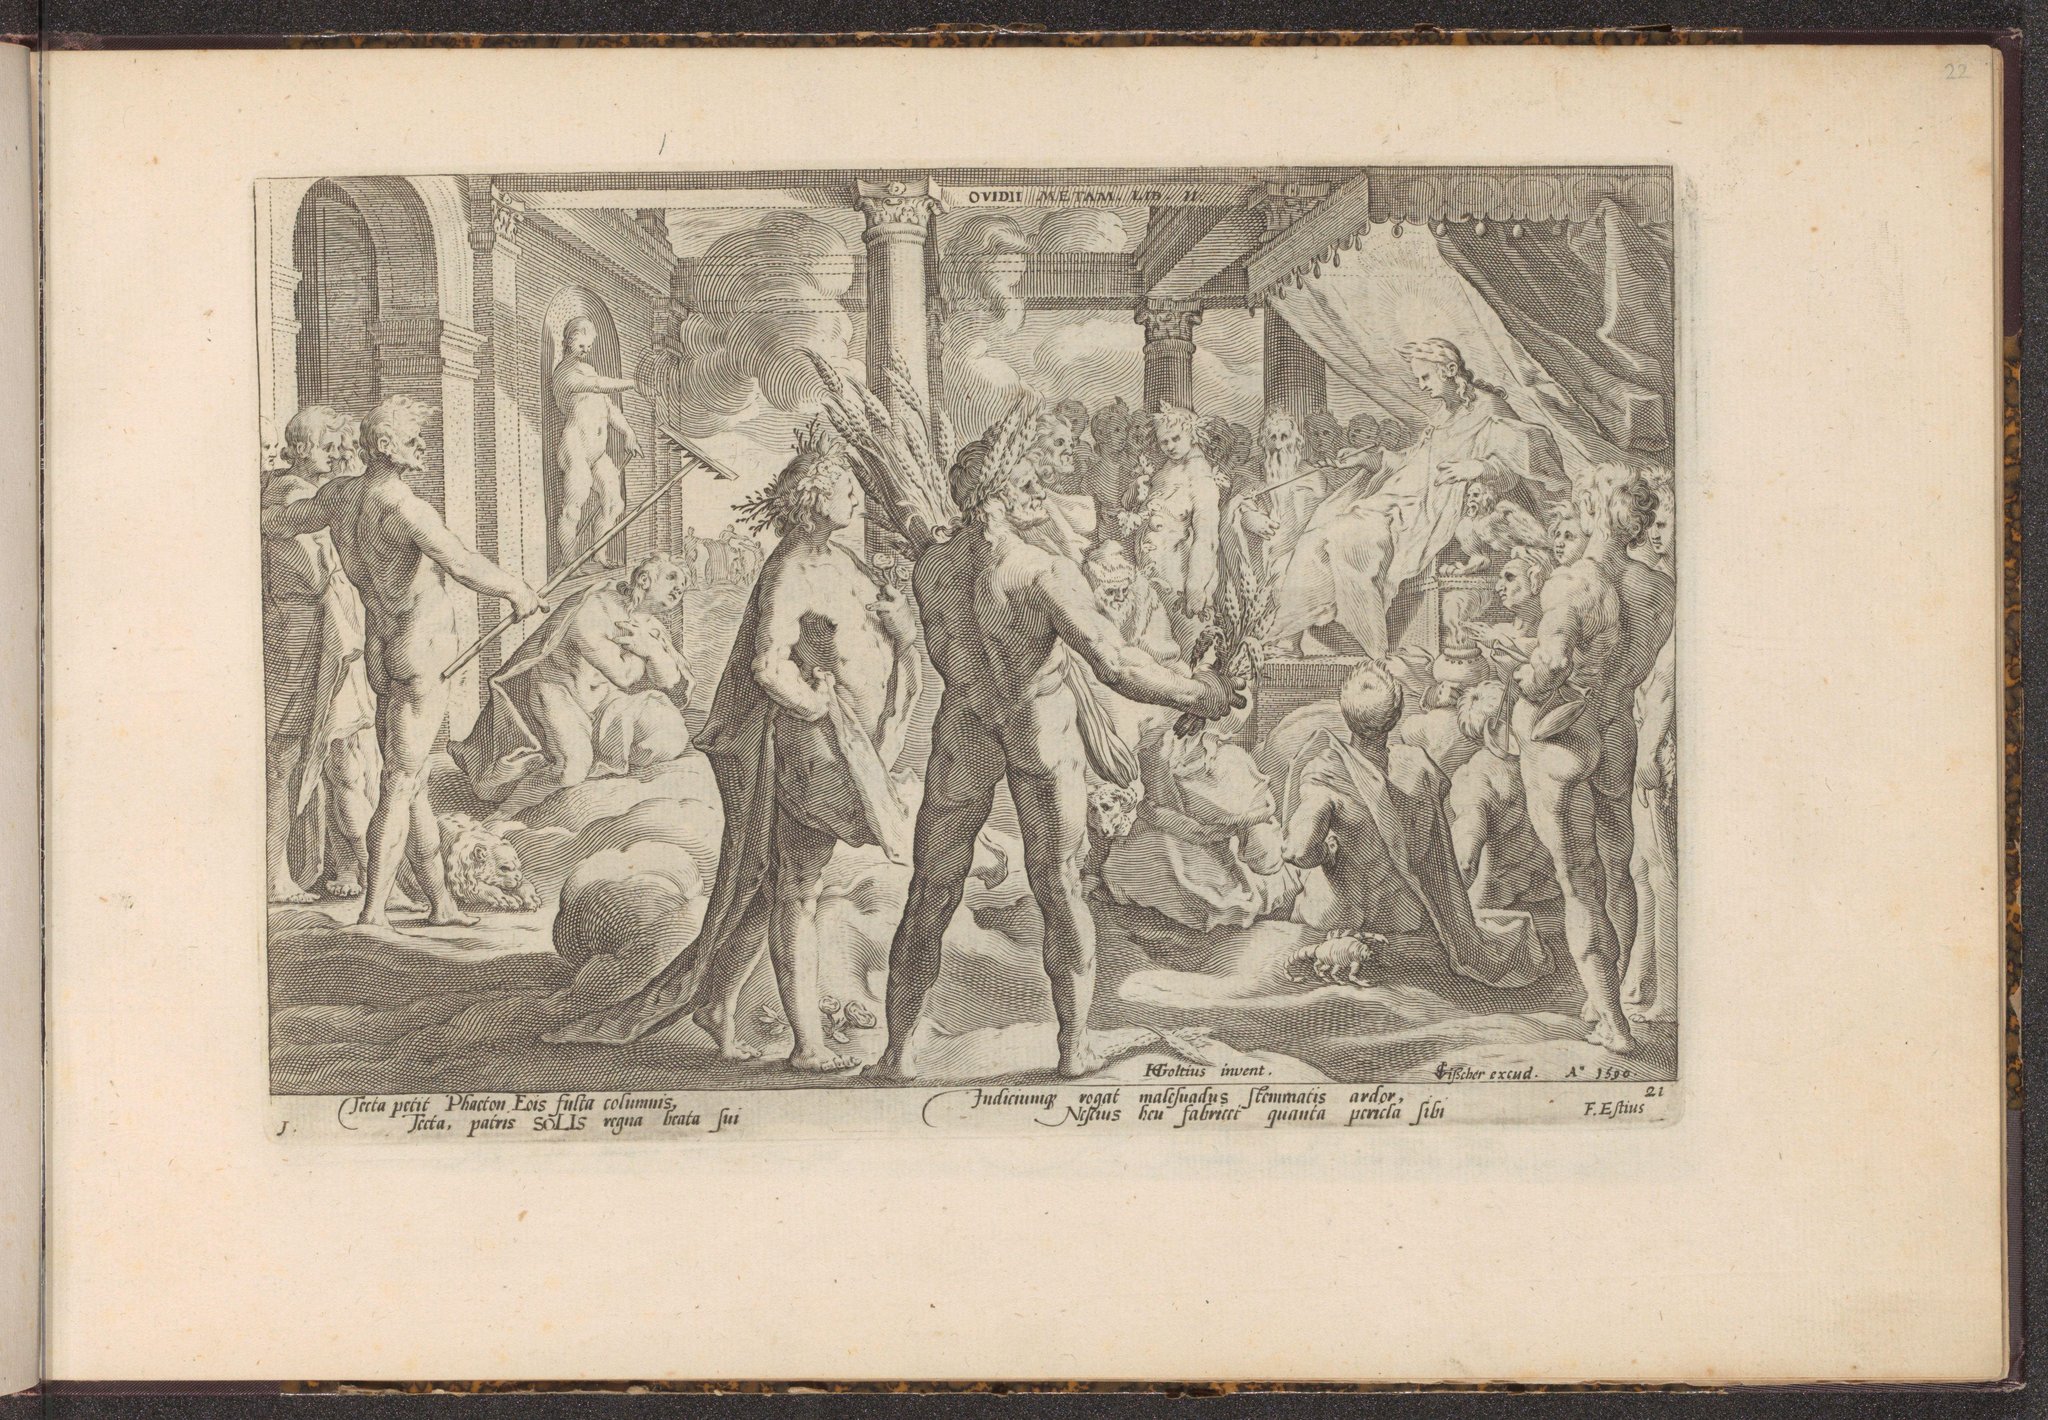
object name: album leaf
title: Ovidii Metam. Lib. II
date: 1590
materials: paper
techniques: engraving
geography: amsterdam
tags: phaethon asks apollo (sol) for the chariot of the sun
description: In het paleis van de zonnegod Helios vraagt Phaëton een bewijs dat de zonnegod zijn vader is. Phaëton knielt voor zijn vader, zittend op een troon onder een baldakijn. Om zijn vaderschap te bewijzen mag Phaëton vragen wat hij wil. De jongen vraagt daarop om de zonnewagen. Op de voorgrond mogelijk de personificaties van de lente en de zomer. Onder de voorstelling twee keer twee versregels in het Latijn. De prent maakt deel uit van een album.